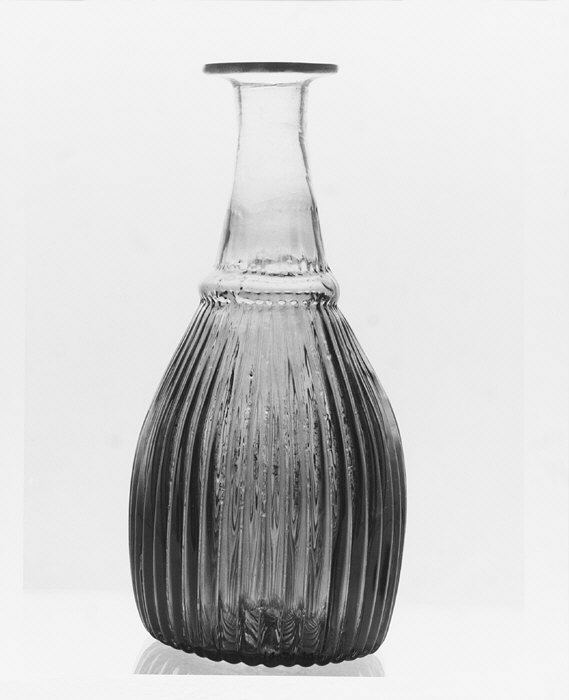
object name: bottle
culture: american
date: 1820-1840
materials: glass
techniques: glassblowing, molding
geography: united states